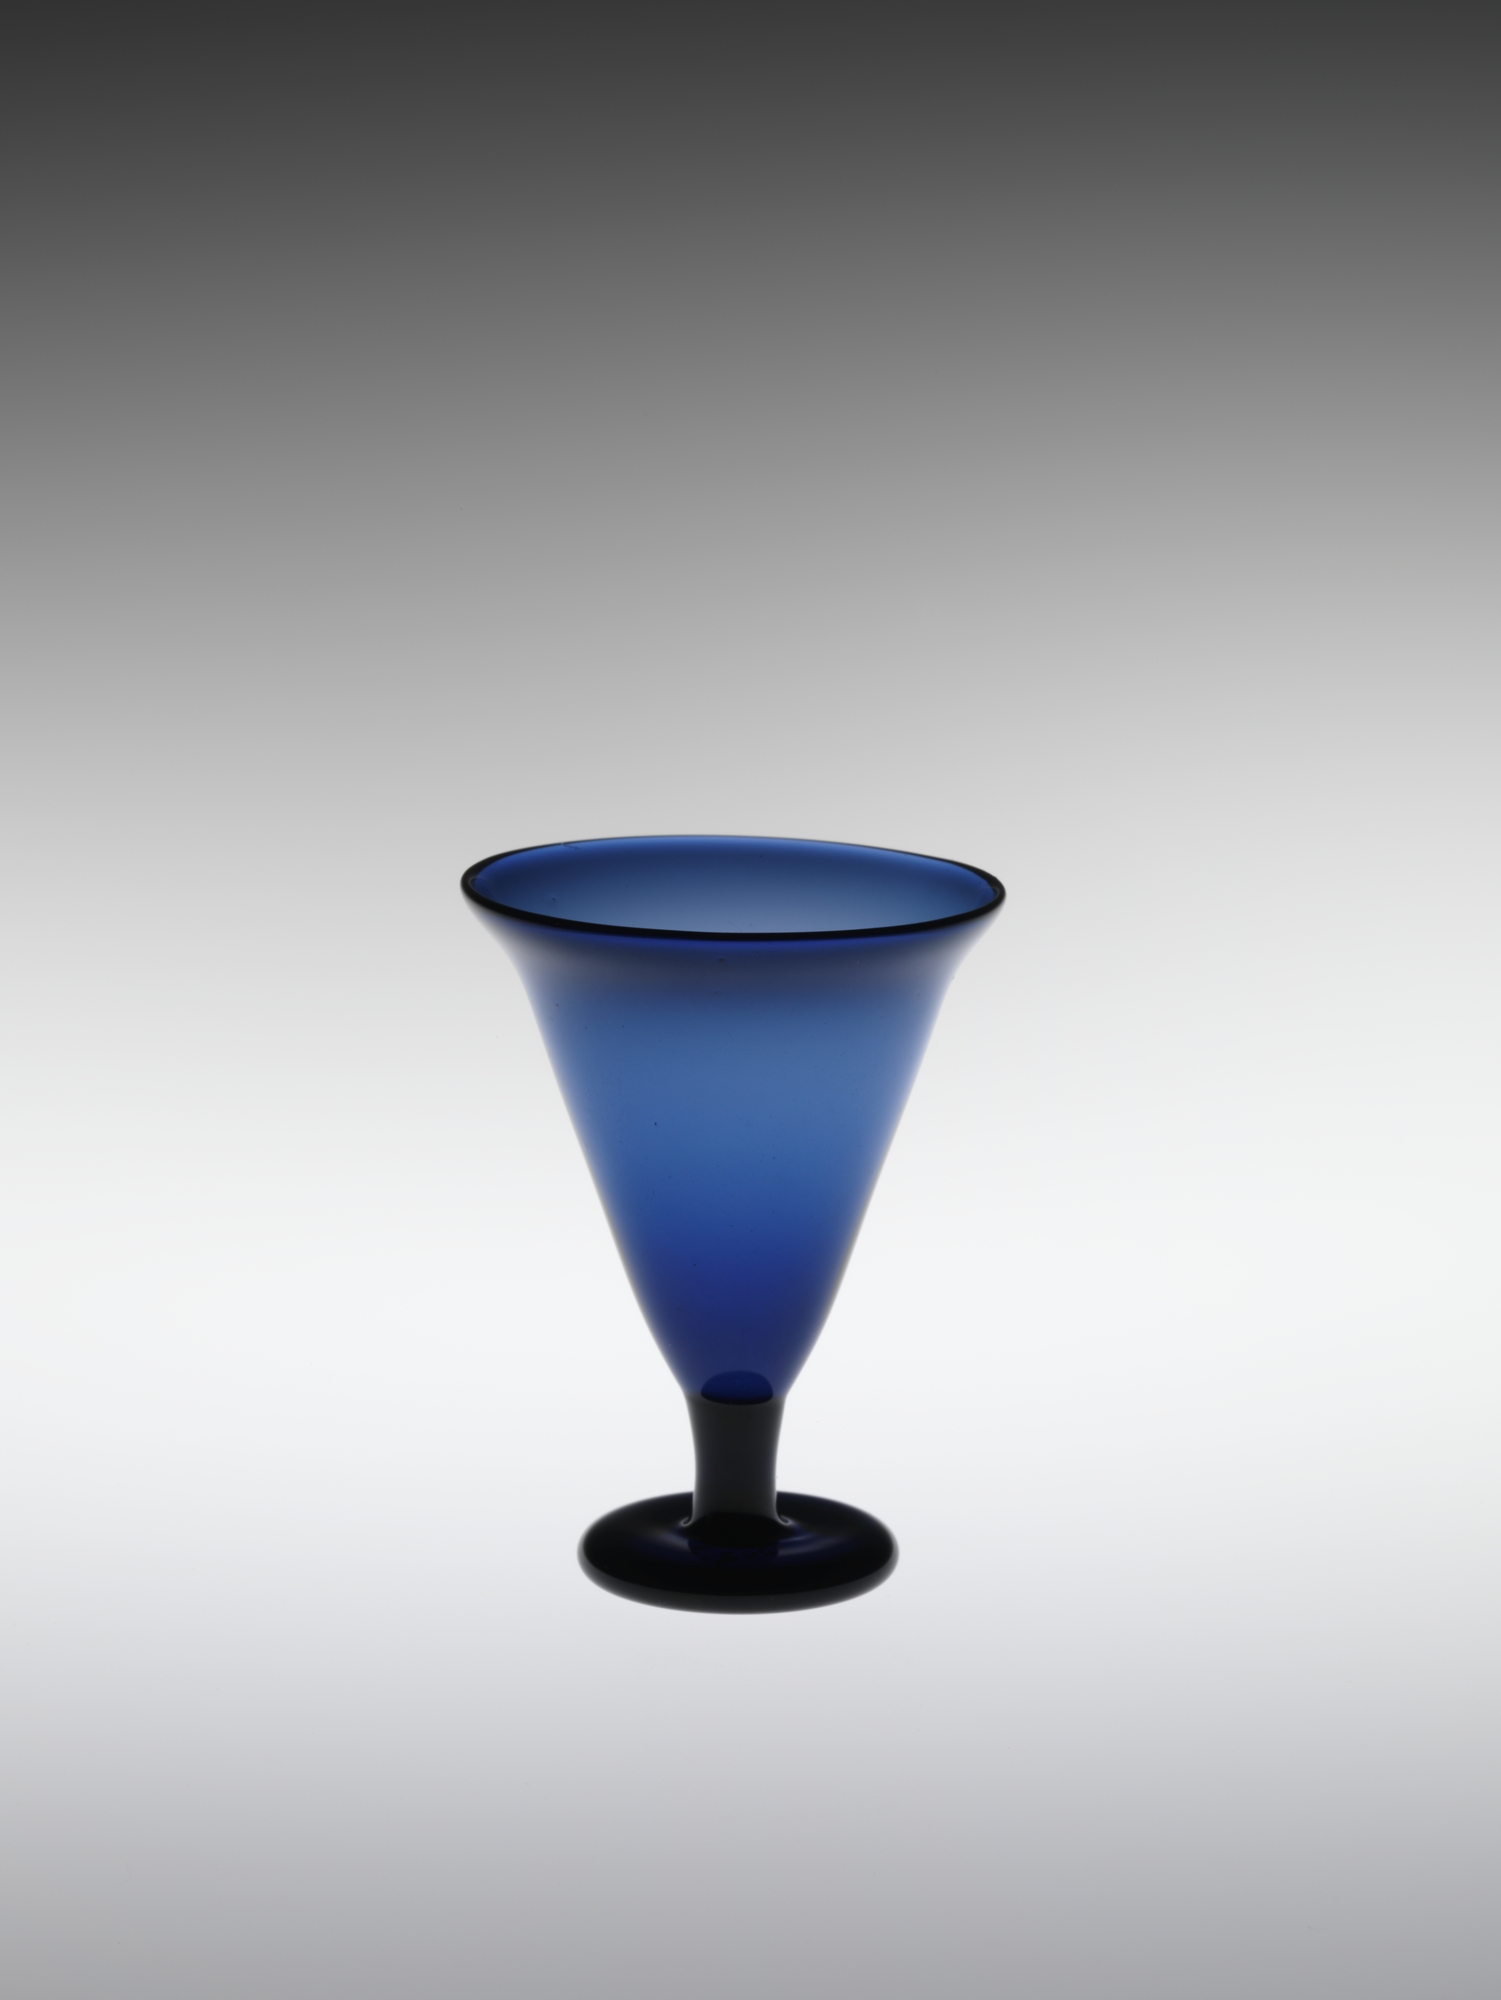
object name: wine cup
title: Small Wine Cup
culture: japanese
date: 1801-1900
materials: glass